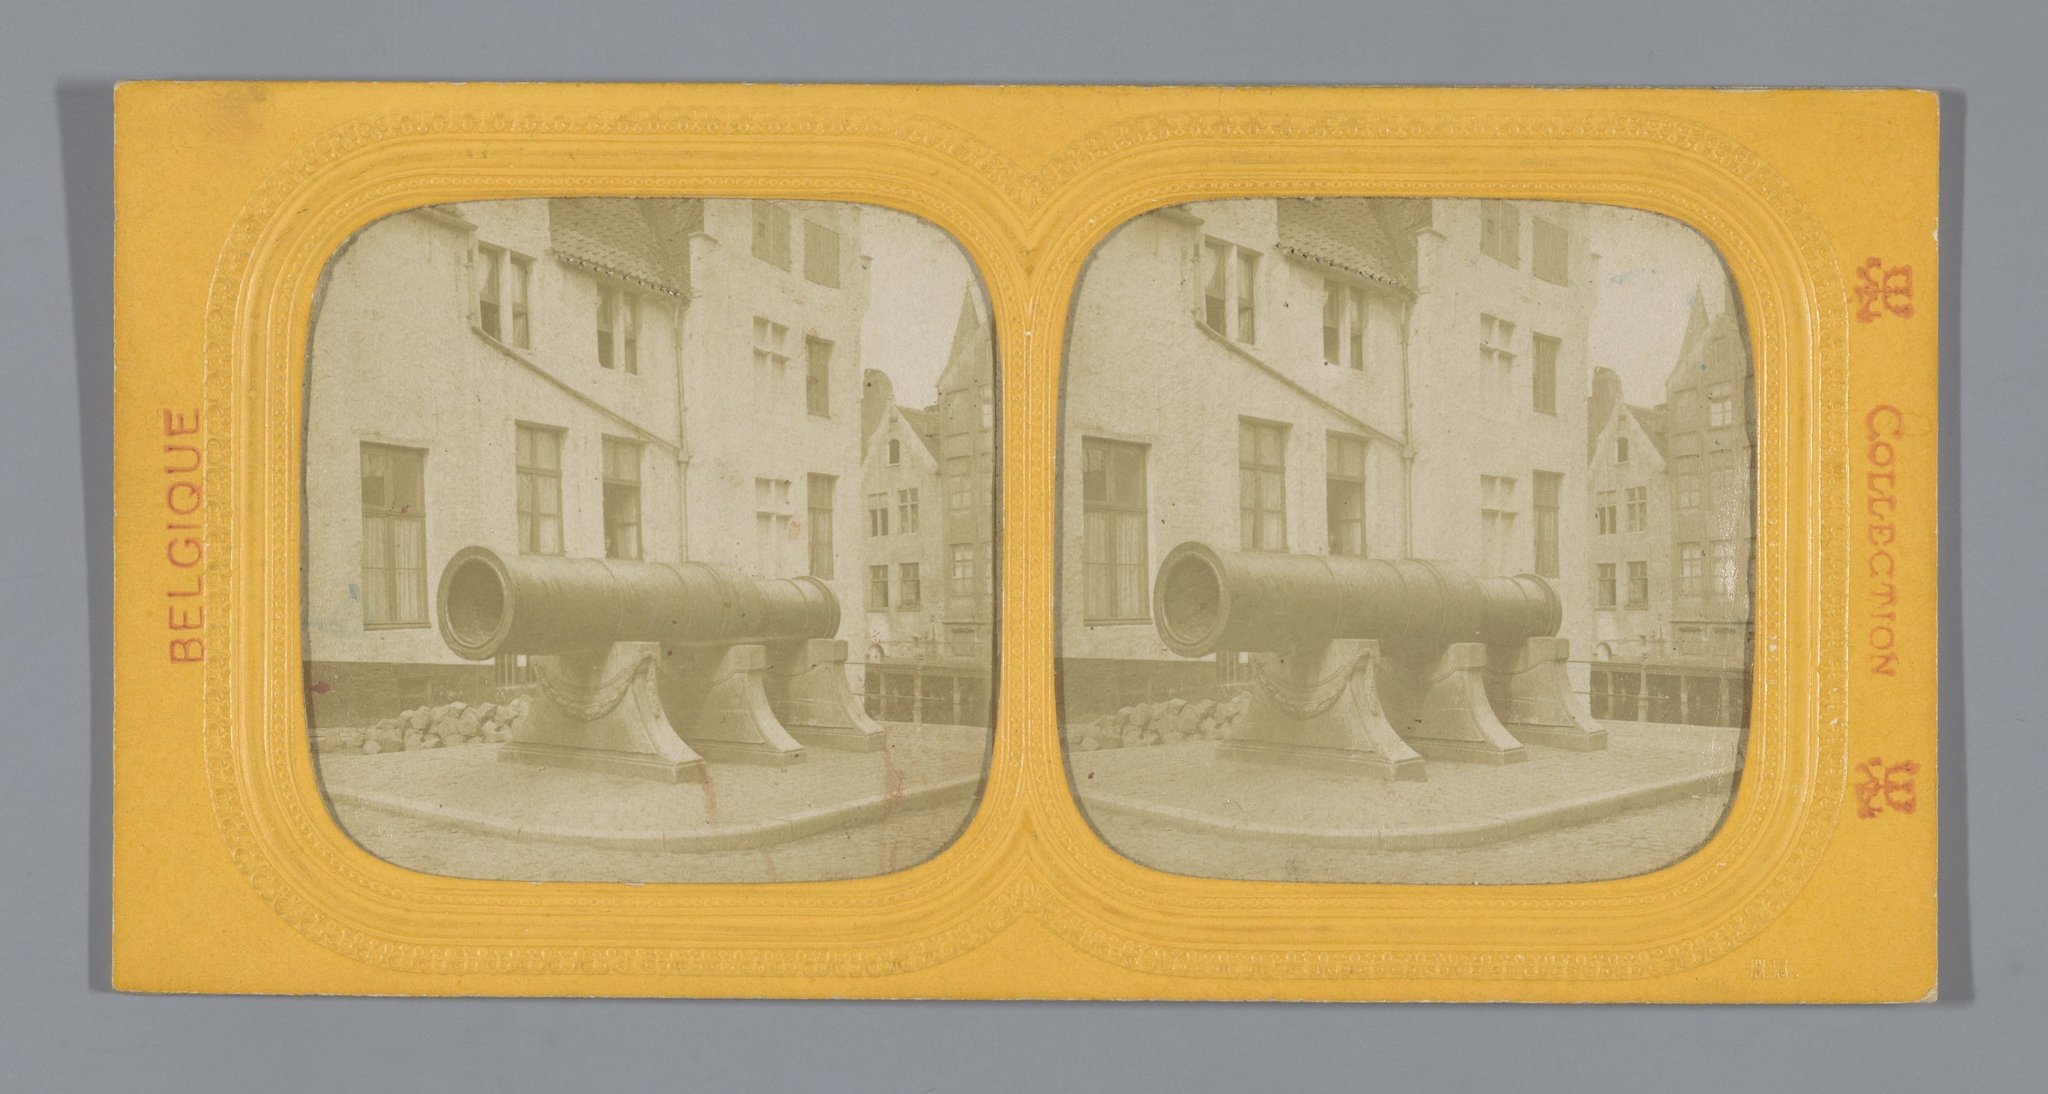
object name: tissue stereograph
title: Collection Belgique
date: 1865-1875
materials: cardboard, paper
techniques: albumen print, hand coloring, perforating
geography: ghent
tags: firearms: cannon, ghent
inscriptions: number: ‘25’, monogram: ‘H.N.’